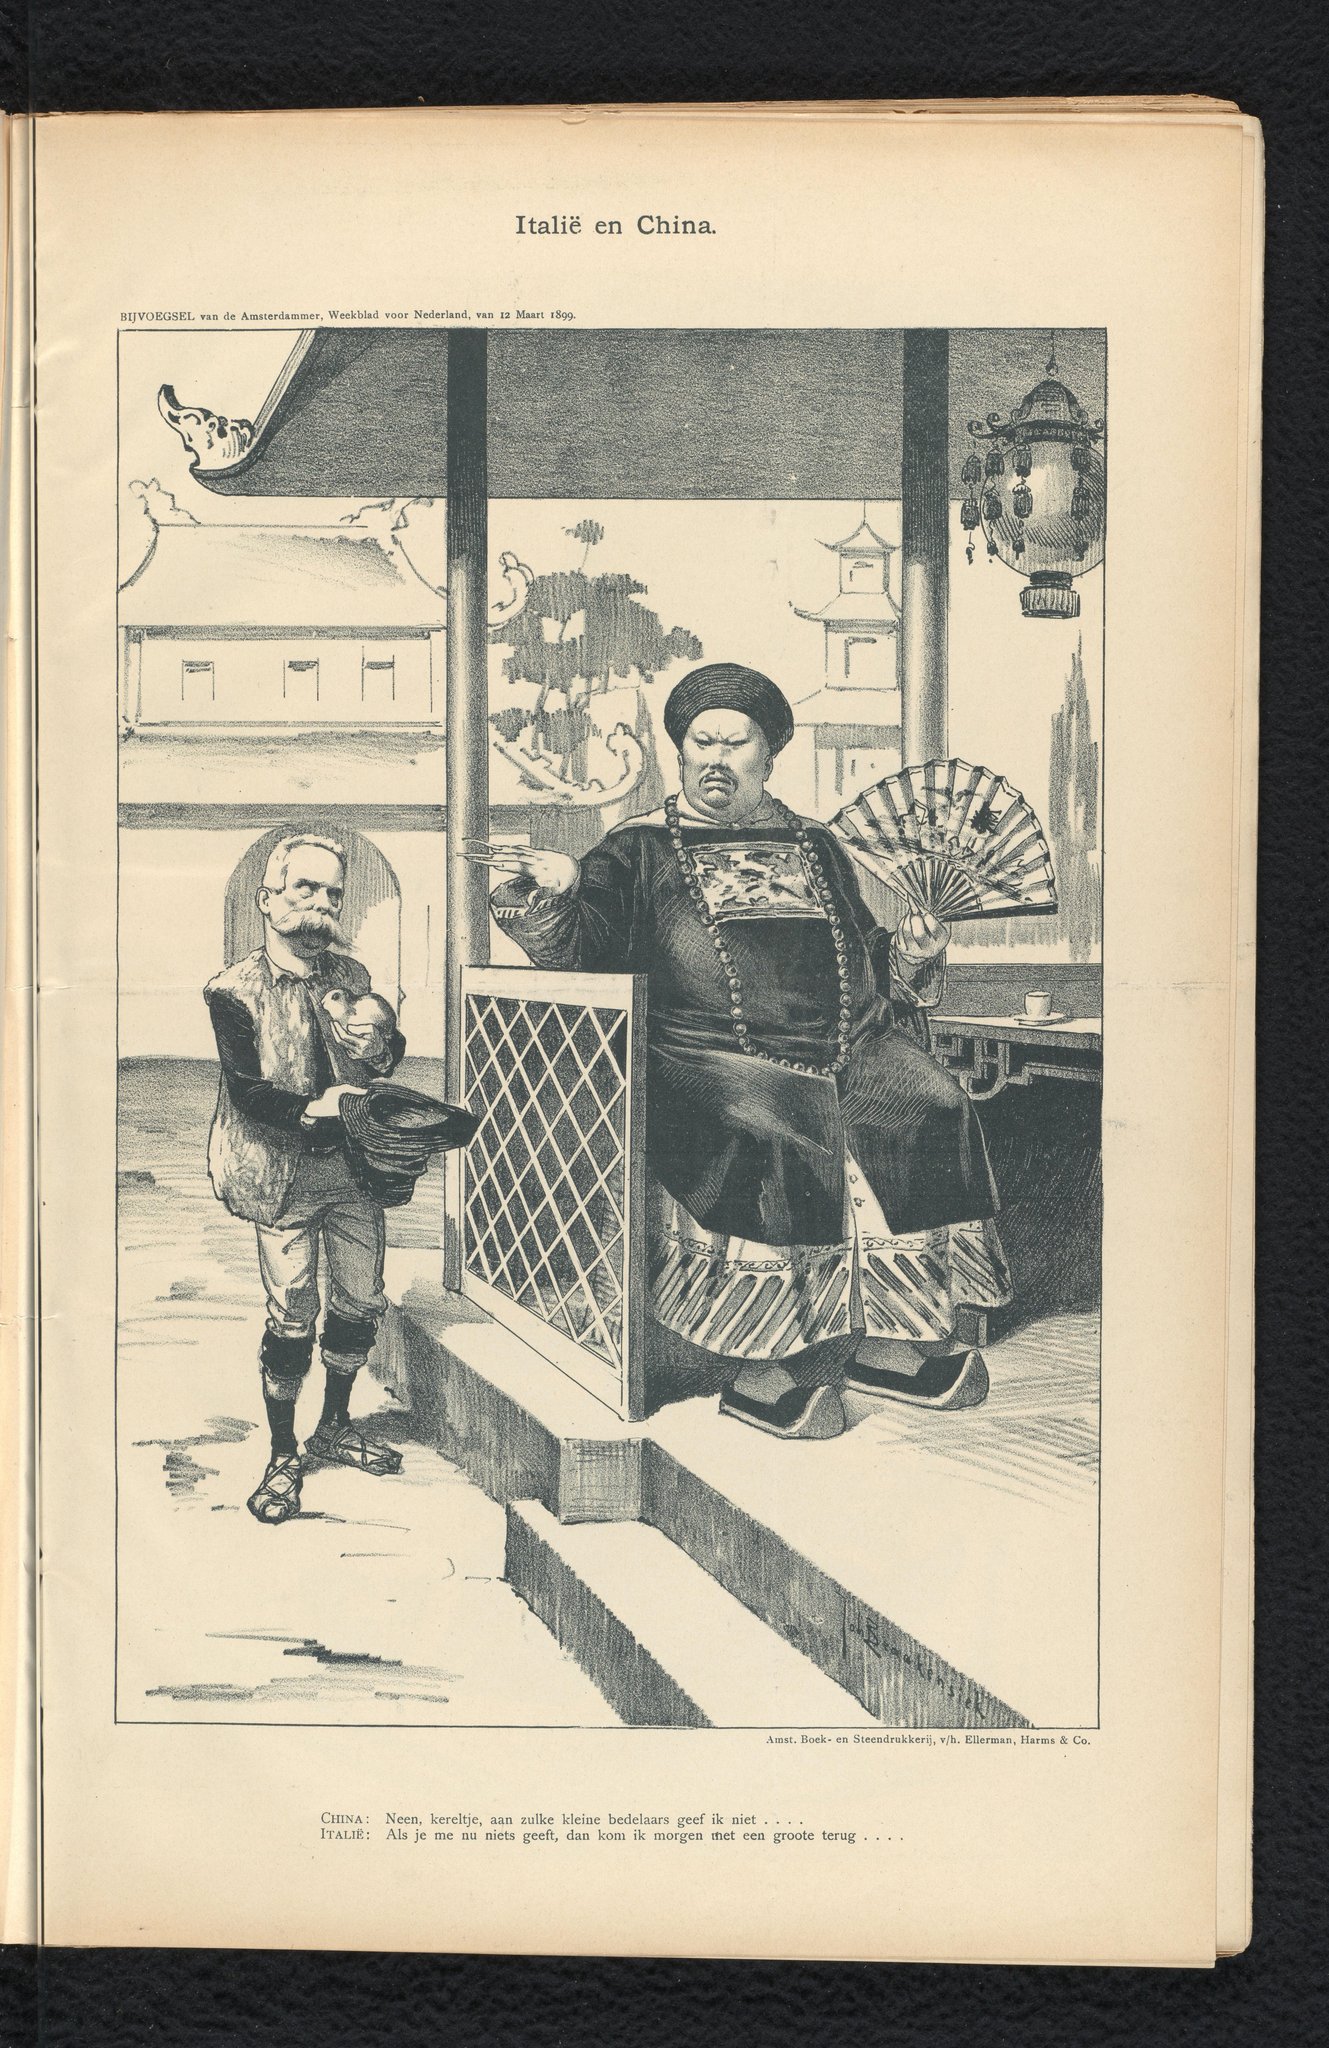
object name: cartoon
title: Italië en China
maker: johan braakensiek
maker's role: draughtsman, print maker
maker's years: 1858-1940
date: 1899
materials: paper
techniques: lithograph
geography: amsterdam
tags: personifications of countries, nations, states, districts, etc., beggar, political caricatures and satires, china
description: Gepubliceerd als bijvoegsel bij 'De Amsterdammer' van 12 maart 1899.